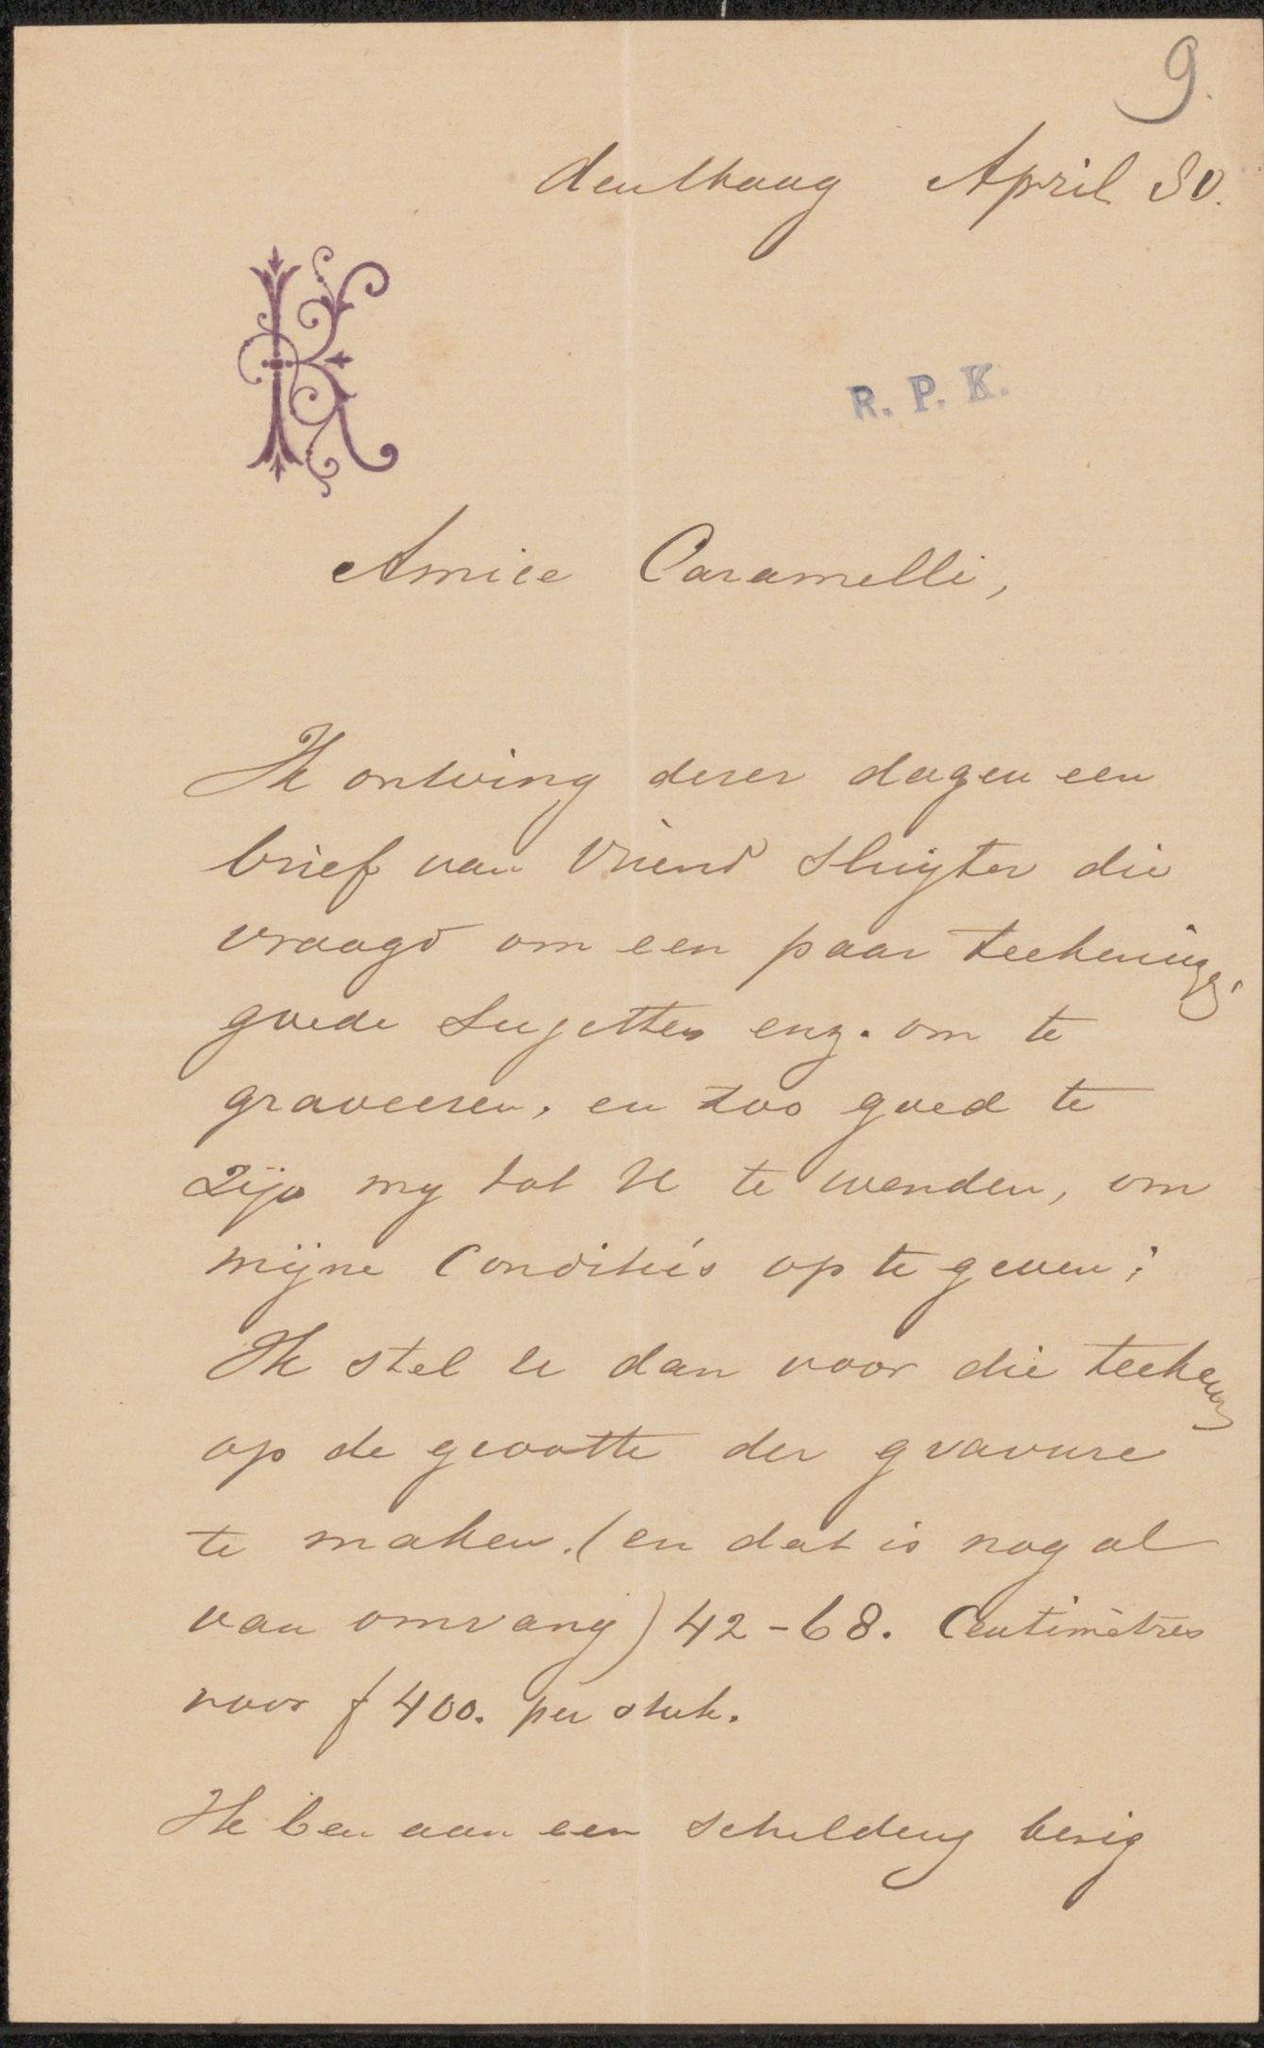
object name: letter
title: Brief aan de heer Caramelli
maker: mari ten kate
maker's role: draughtsman, painter, print maker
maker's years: 1831-1910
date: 1804-1880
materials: ink, paper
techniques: pen, printing, writing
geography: the hague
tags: dirk jurriaan sluyter, drawing, the graphic arts, painting (including book-illumination, miniature-painting)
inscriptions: collector's mark: Lugt 2233